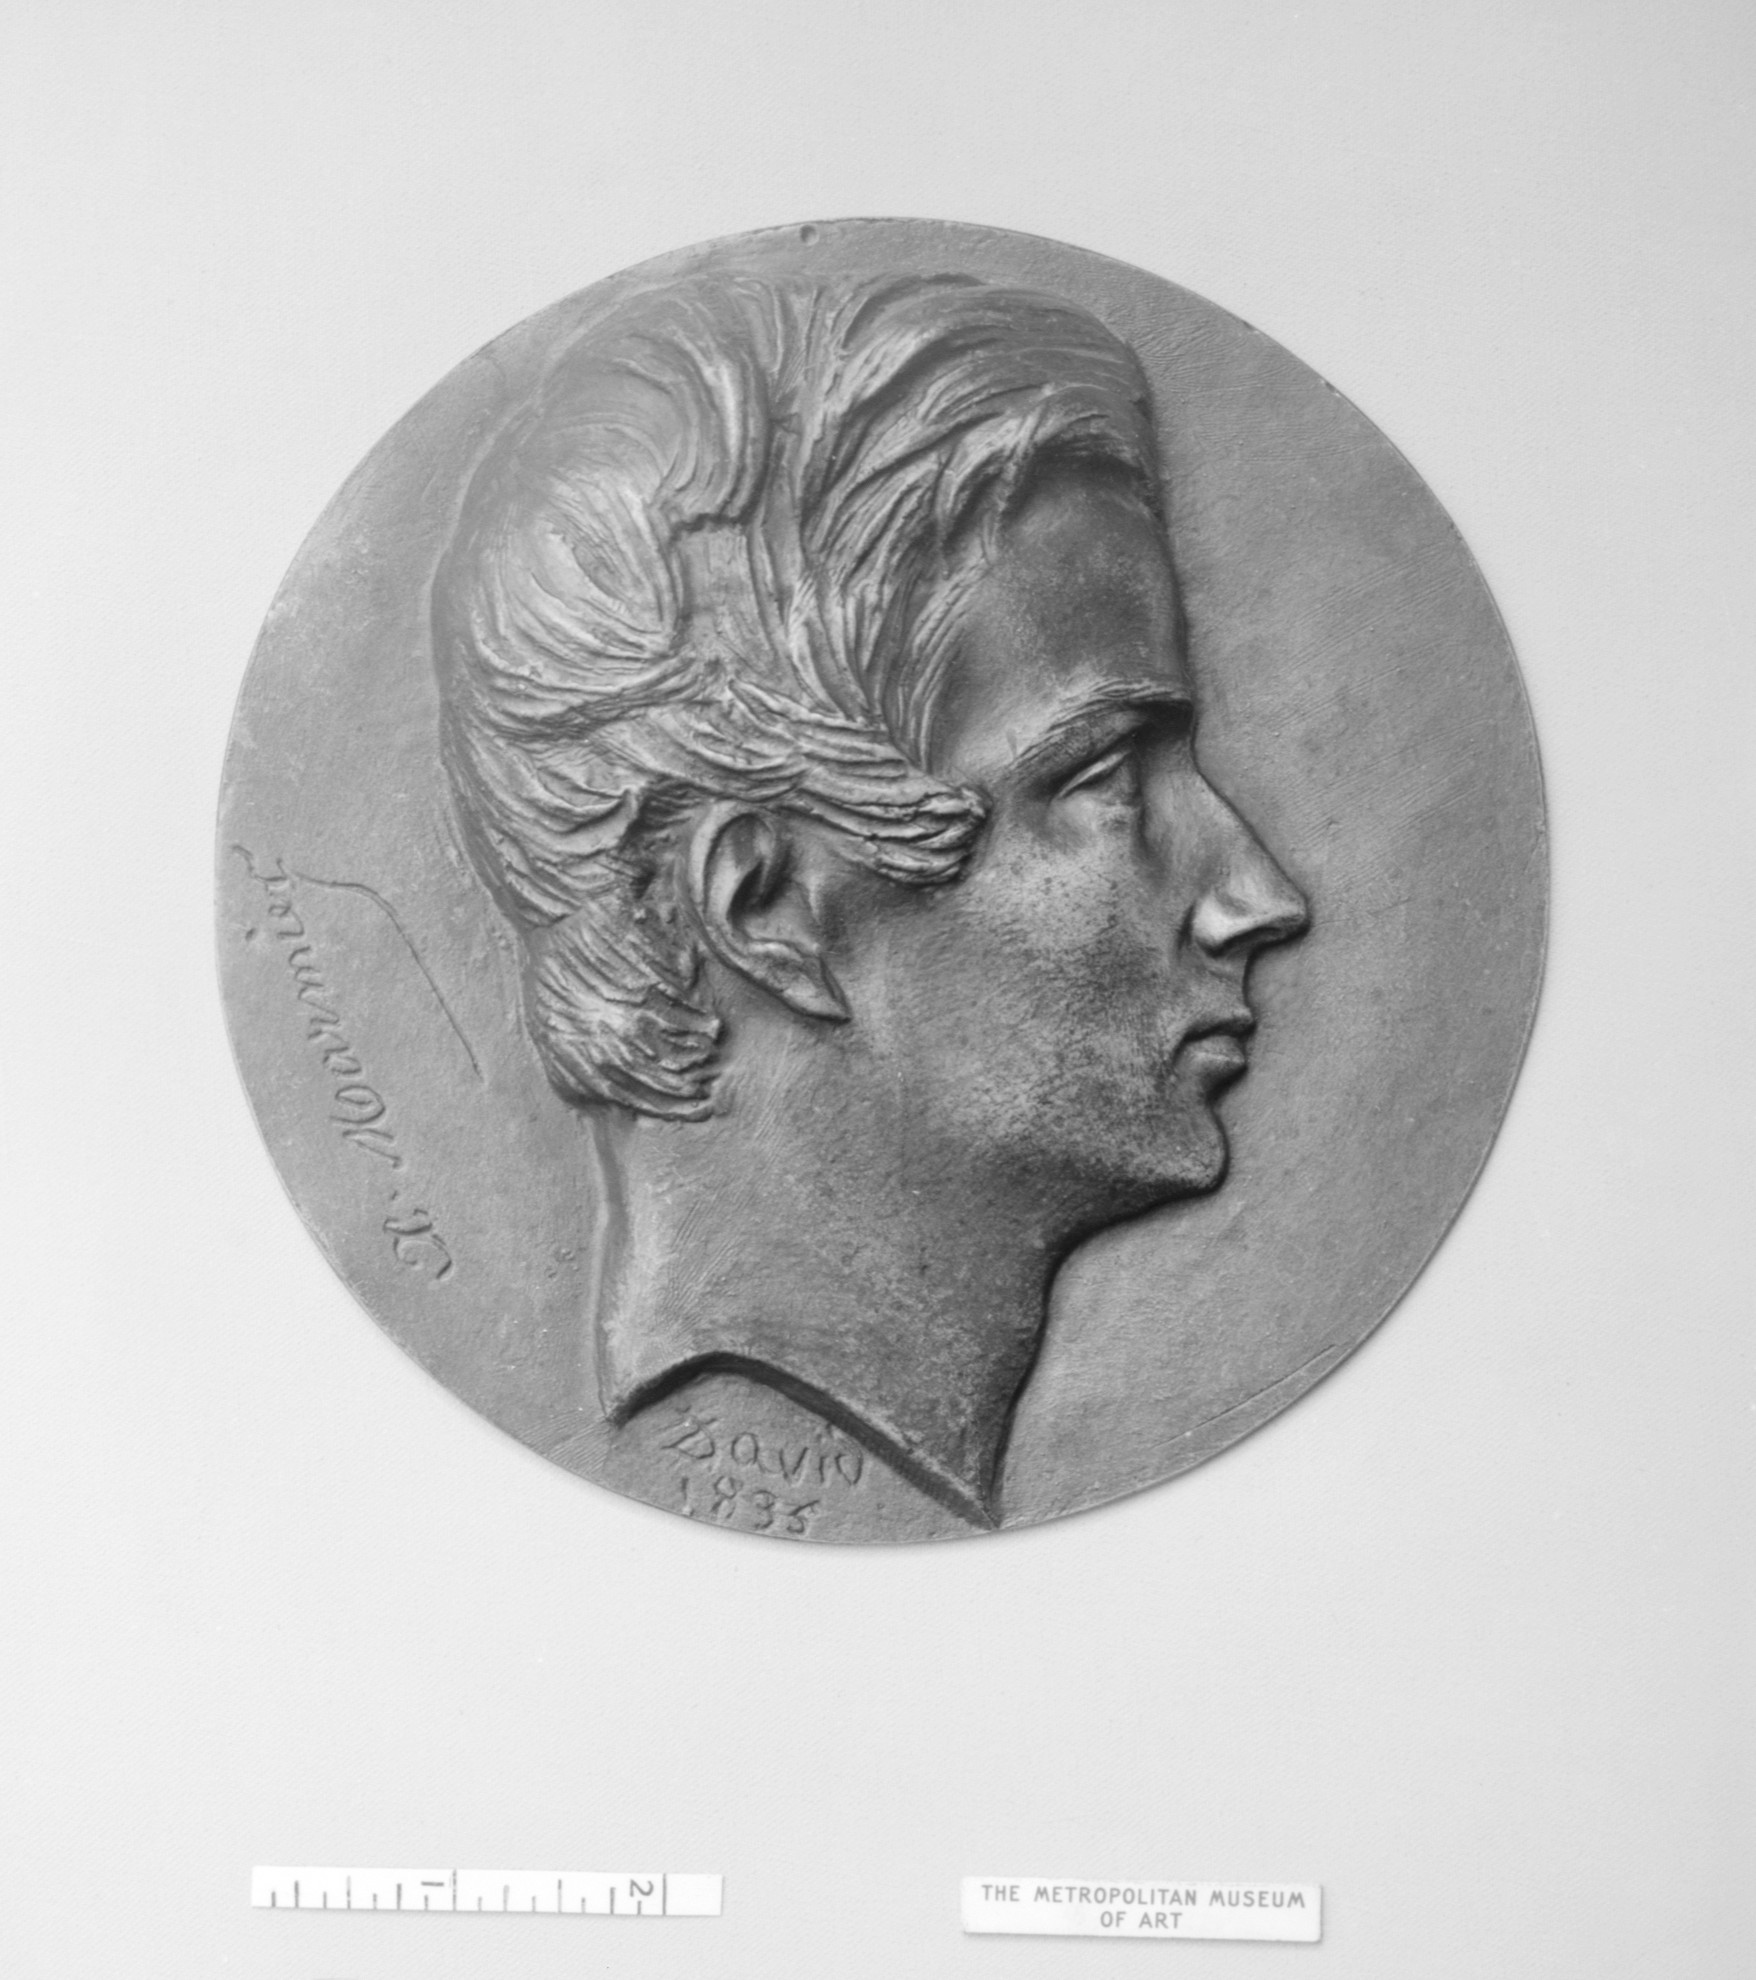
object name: medallion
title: Xavier Marmier (1809–1892), French soldier, traveler, Member of the Academy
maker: pierre jean david d'angers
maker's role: artist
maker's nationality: french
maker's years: 1788-1856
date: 1835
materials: bronze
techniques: casting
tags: men,profiles